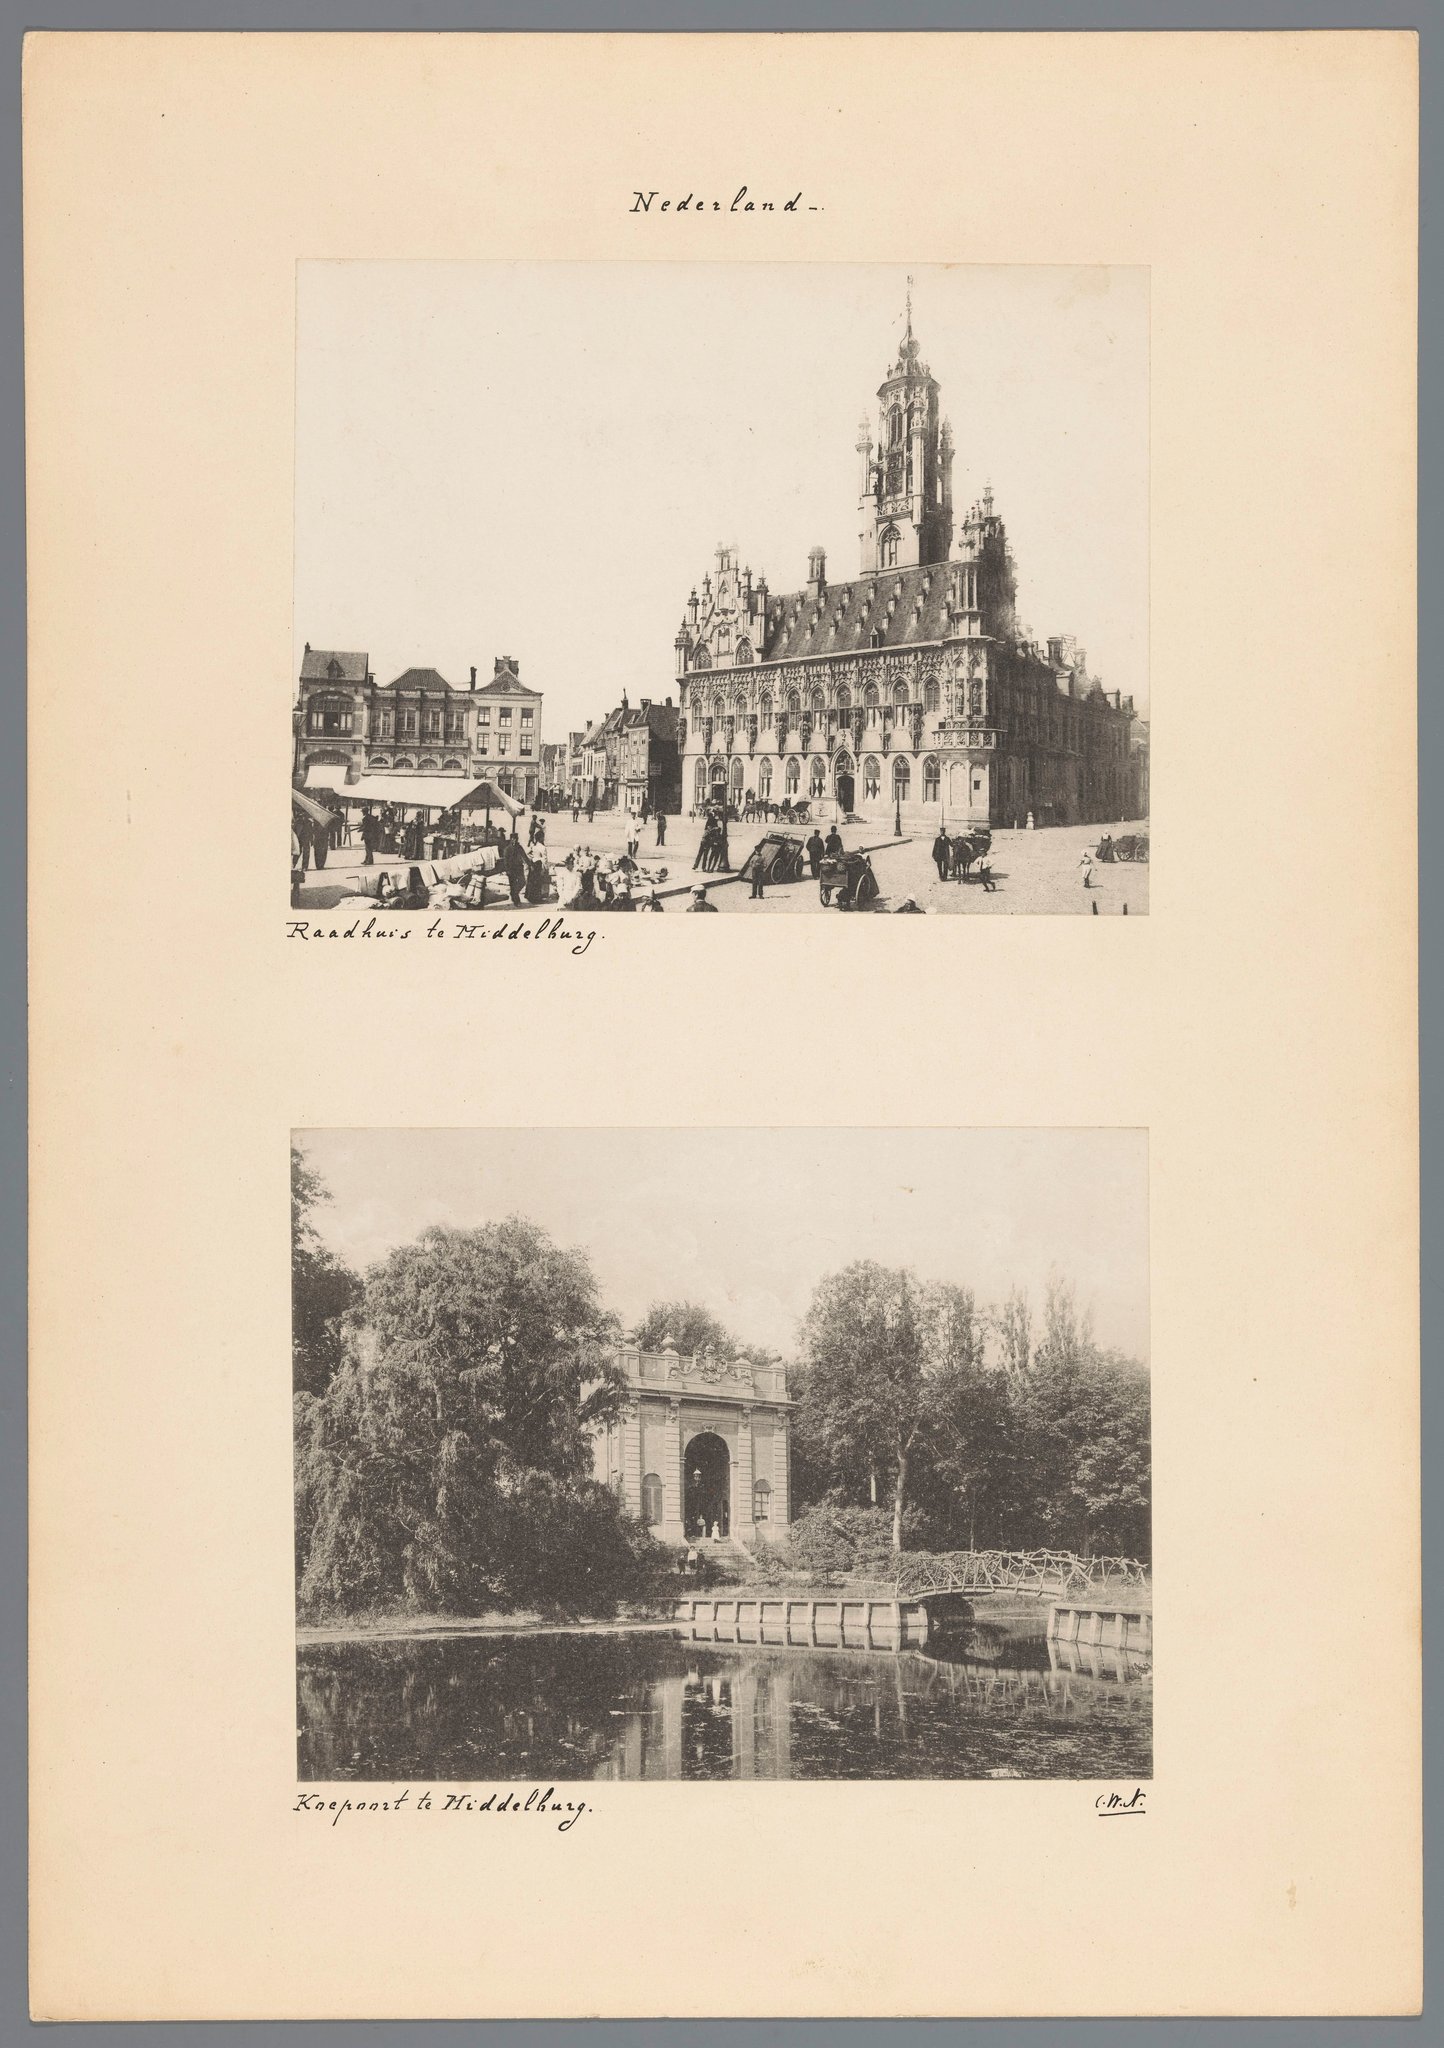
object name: photograph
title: Overzicht van twee gebouwen te Middelburg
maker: Anonymous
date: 1875-1900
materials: cardboard, paper, ink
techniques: photograph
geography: middelburg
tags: townhall, façade (of house or building), bridge, city-gate, middelburg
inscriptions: collector's mark: ‘KUNSTNIJVERHEIDSCHOOL QUELLINUS AMSTERDAM FRANS HALSSTRAAT 14.’, inscription: ‘CWN.’, inscription: ‘Nederland. Raadhuis te Middelburg. Koepoort te Middelburg.’, collector's mark: ‘INSTITUUT VOOR KUNST- NIJVERHEIDSONDERWIJS GABRIËL METSUSTRAAT No. 16. AMSTERDAM’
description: Boven een gezicht op het stadhuis van Middelburg, onder een gezicht op de Koepoort te Middelburg.